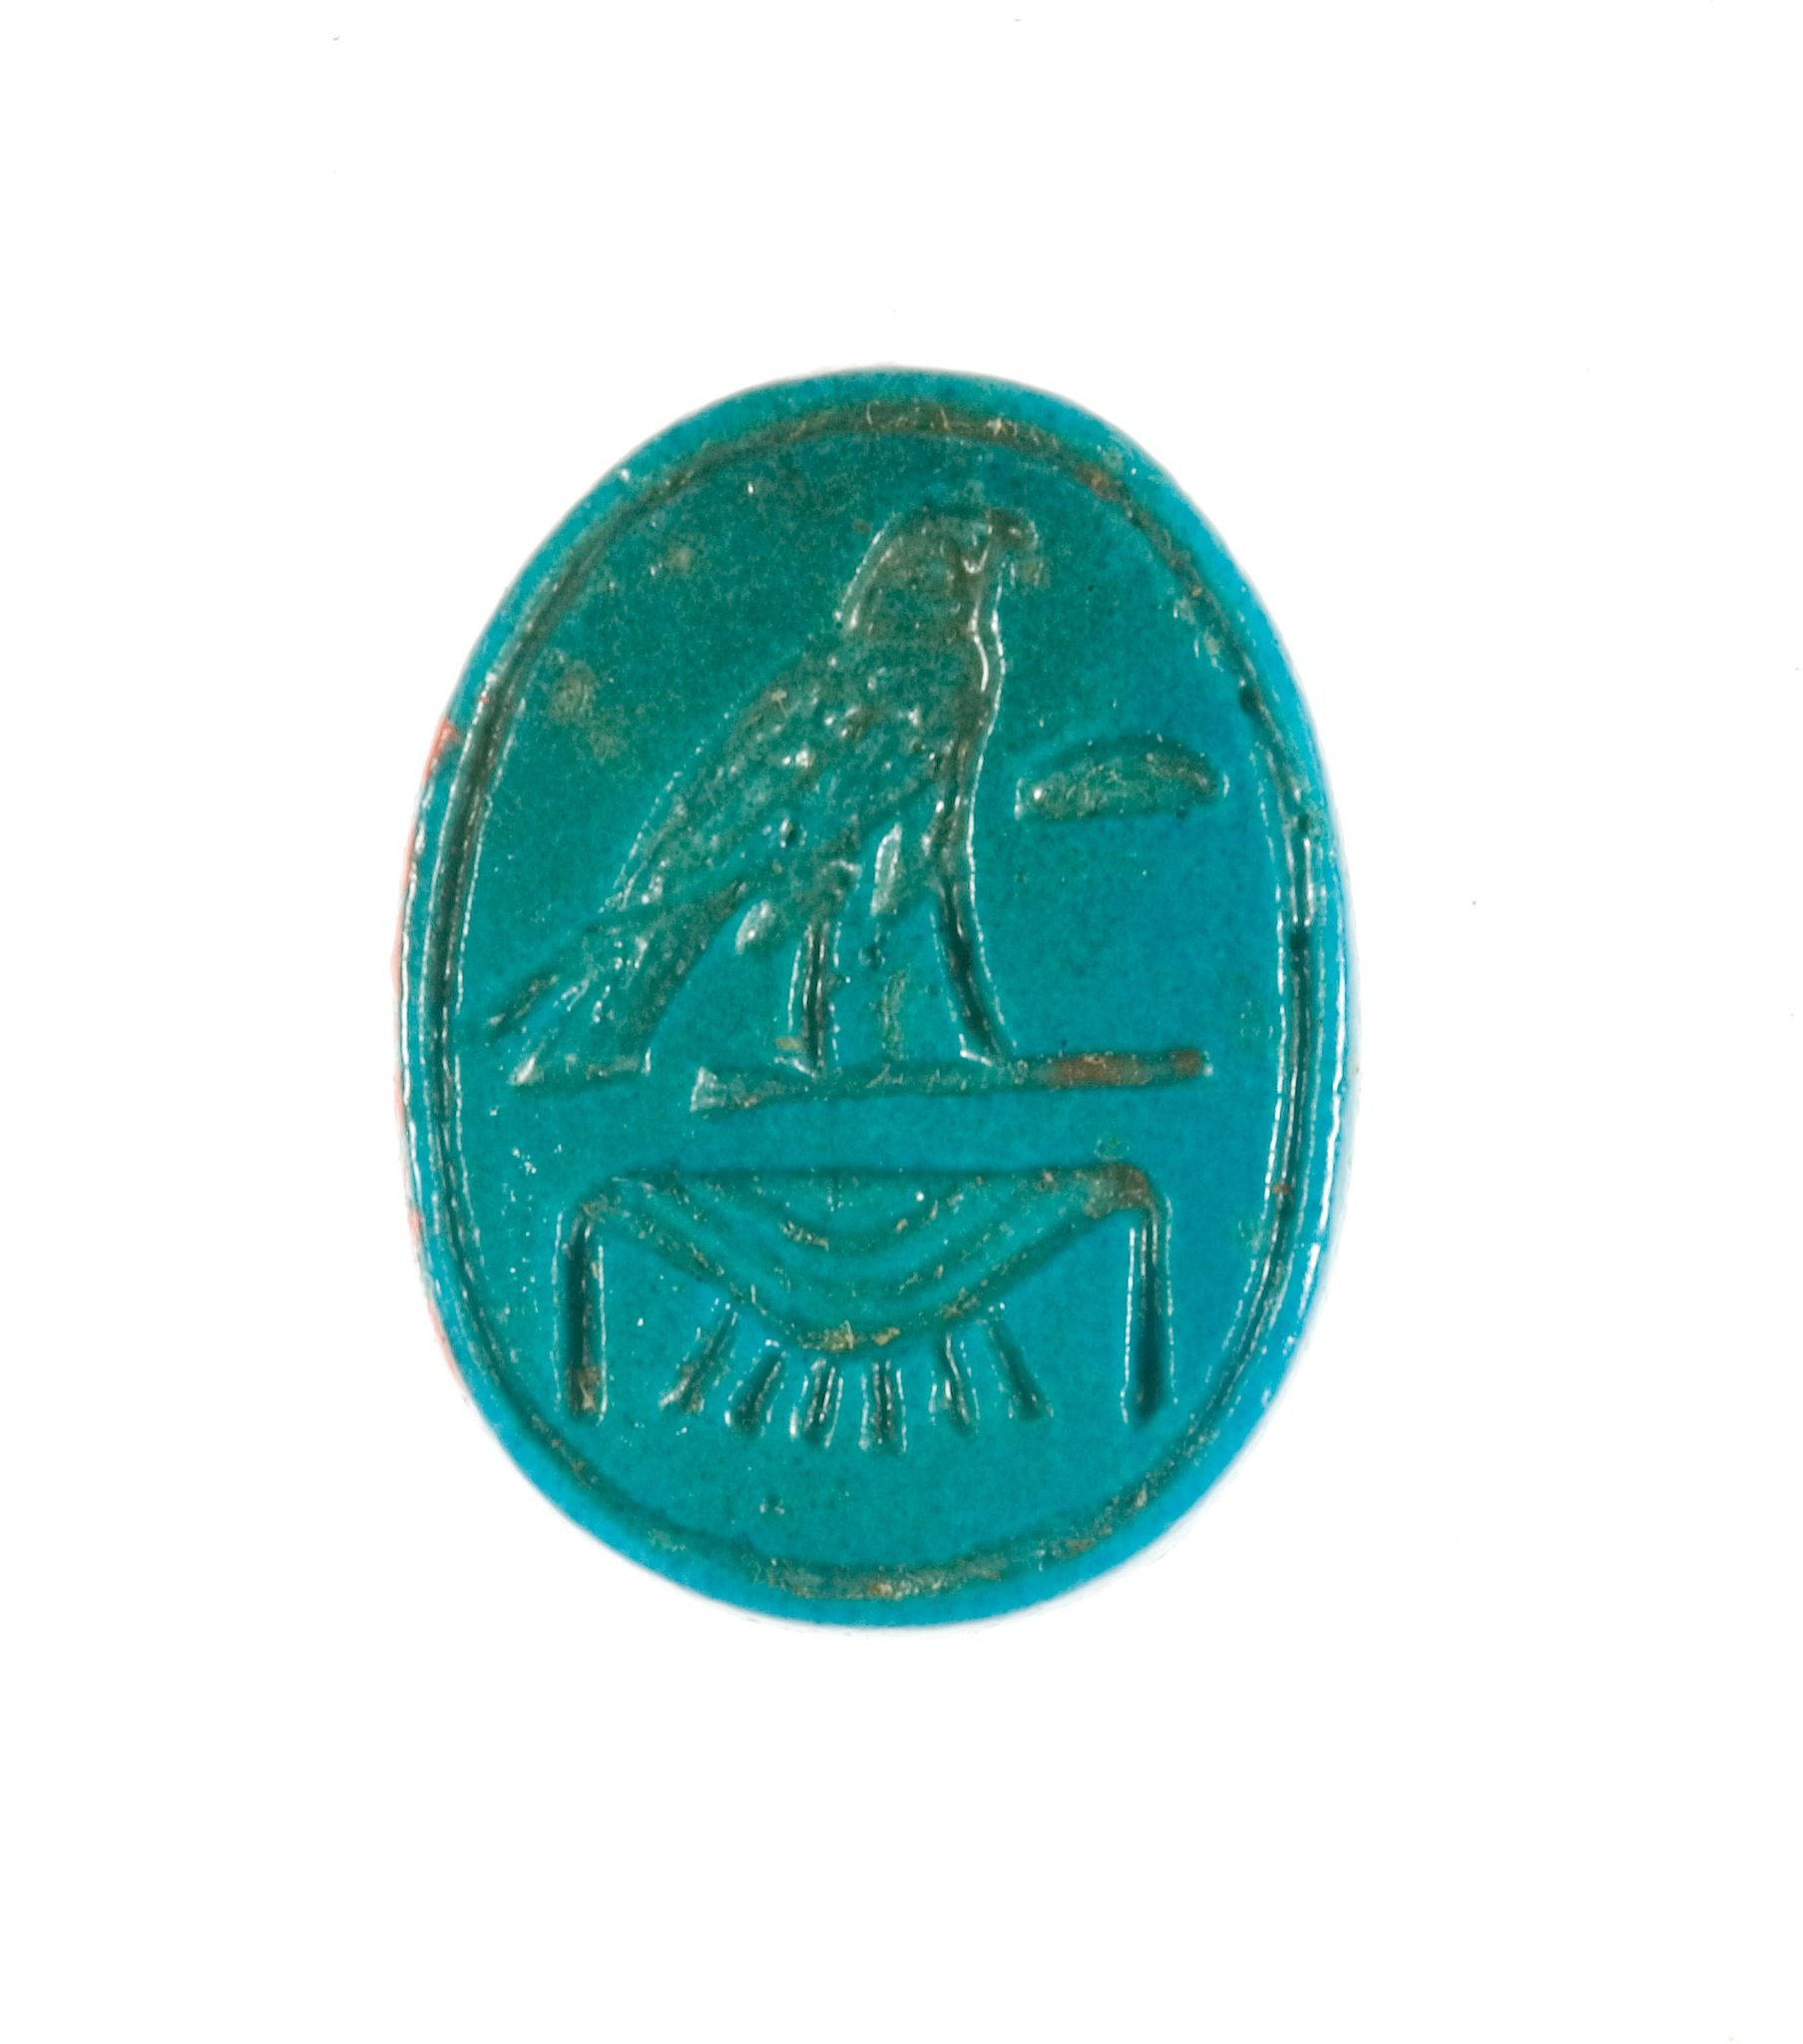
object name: scarab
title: Scarab Inscribed Female Golden Horus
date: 1479-1458 BCE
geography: egypt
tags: hieroglyphs,scarabs